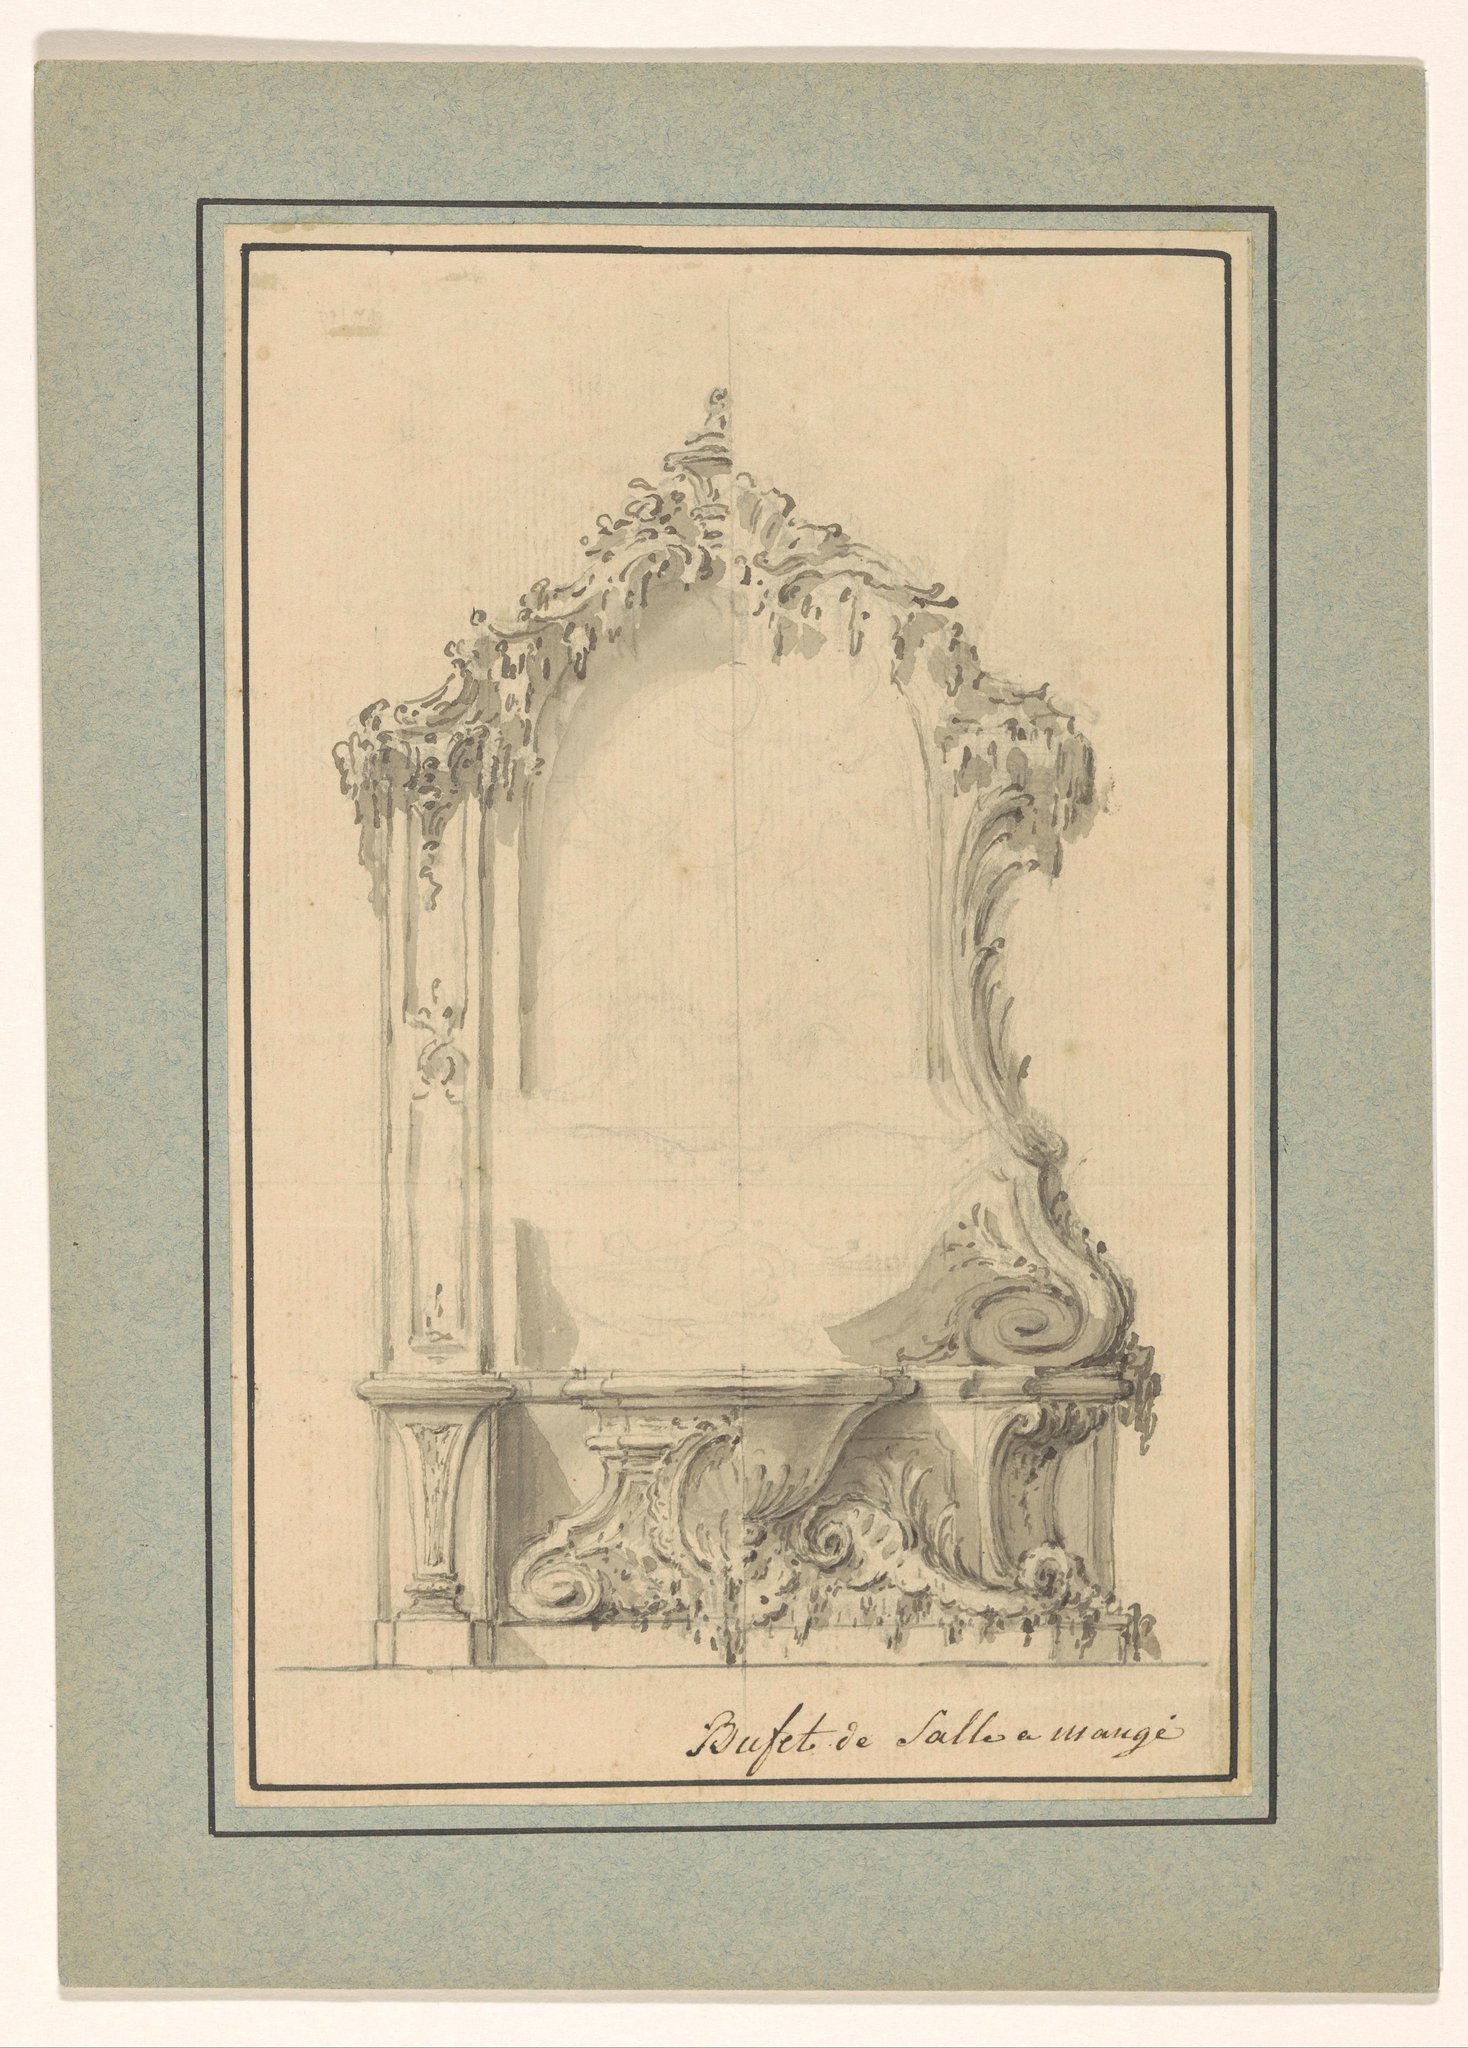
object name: drawing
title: Ontwerptekening buffet met rotsachtige vormen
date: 1735-1750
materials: cardboard, graphite, ink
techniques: brush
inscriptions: inscription: ‘Bufet de Salle a mangé’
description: Buffet met rotsachtige vormen, de linker helft in late Lodewijk XIV-stijl, de rechterhelft in rococo-stijl